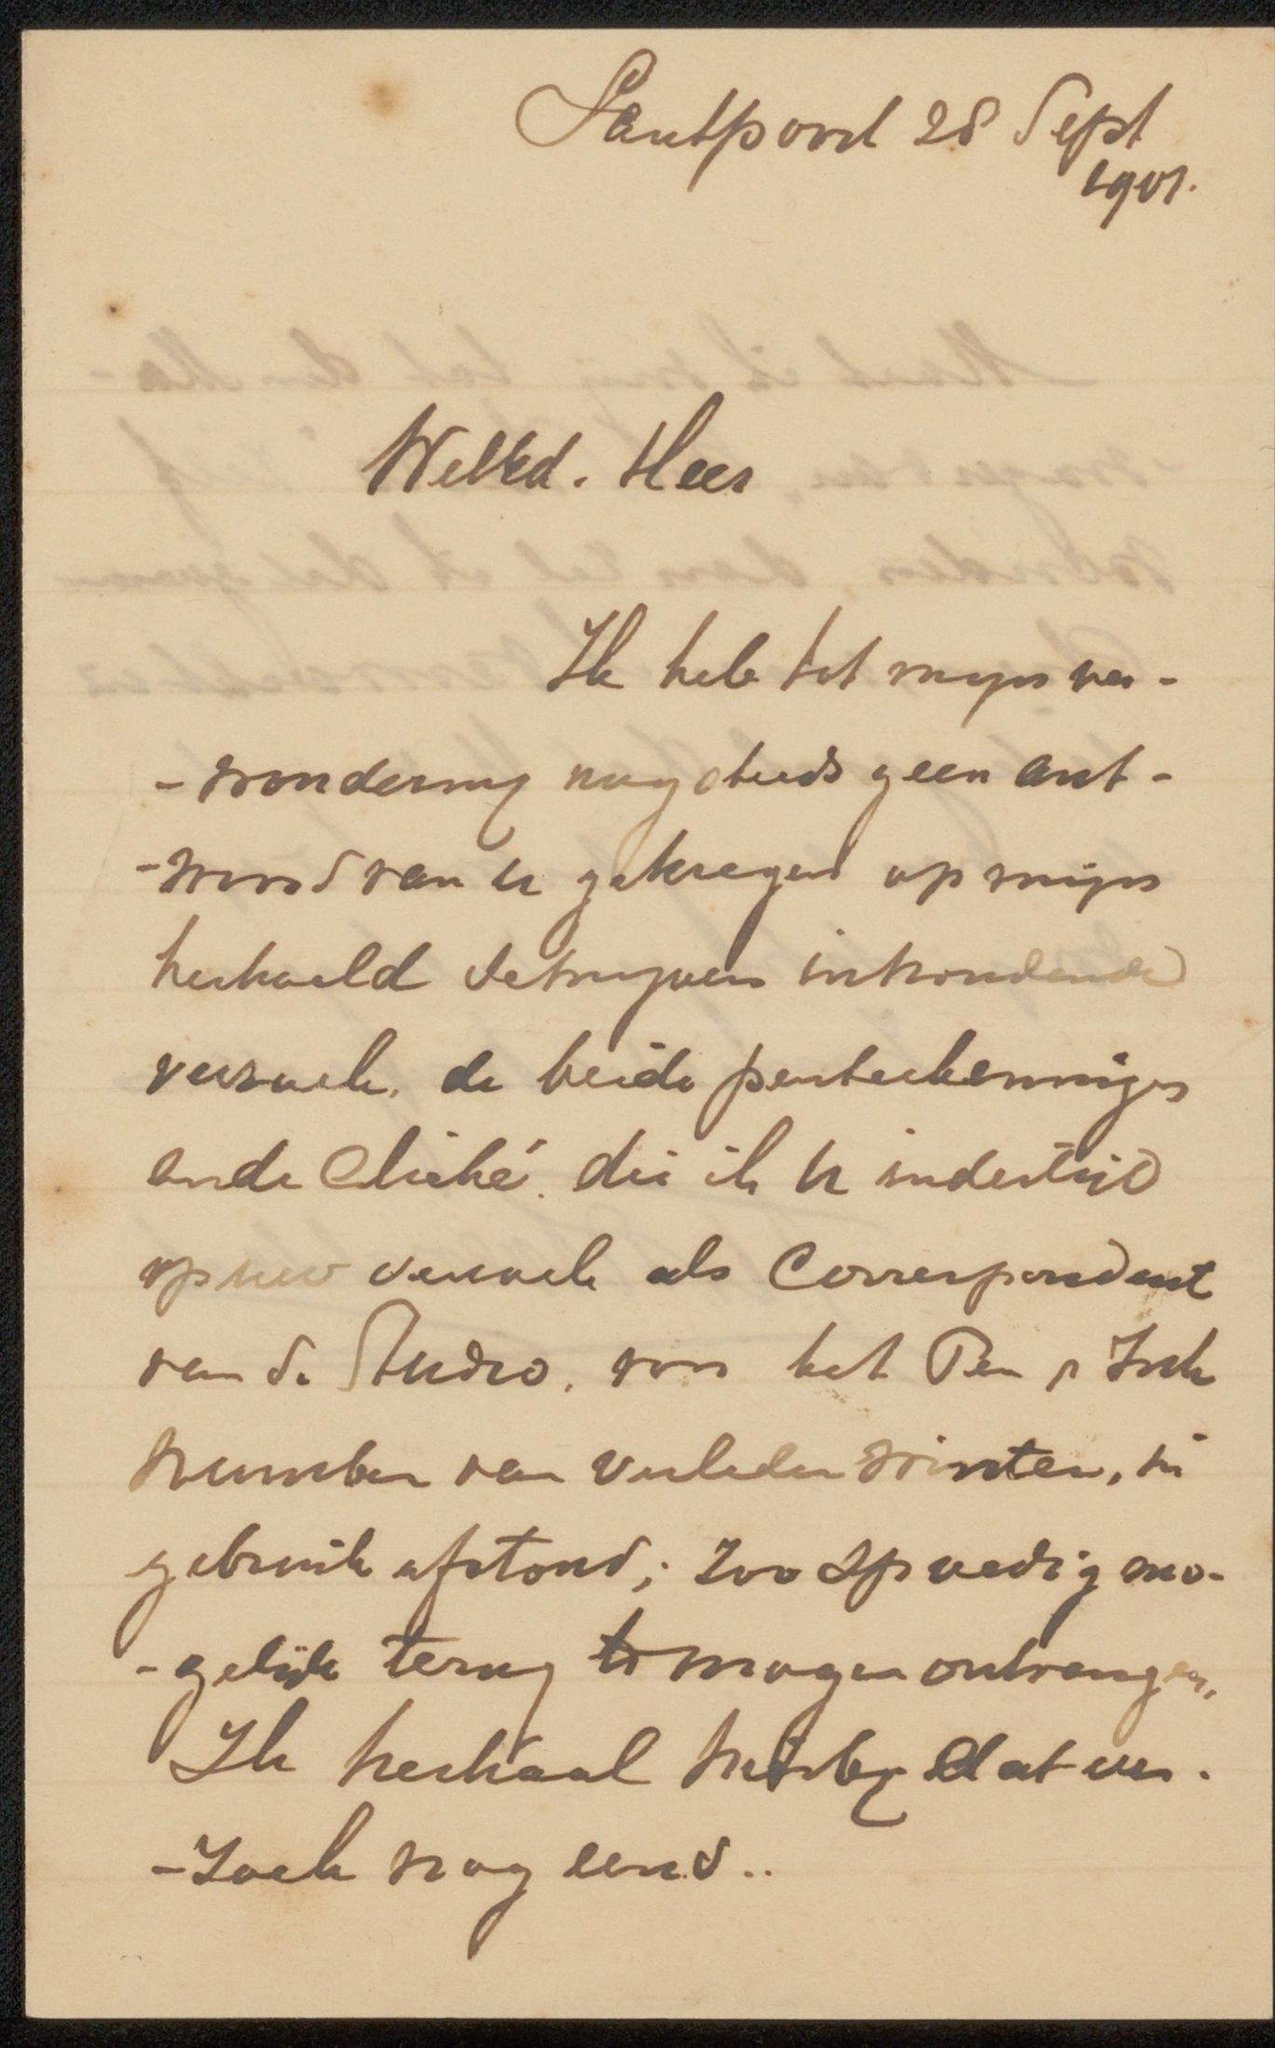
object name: letter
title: Brief aan Philip Zilcken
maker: willem wenckebach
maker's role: designer, draughtsman, painter, print maker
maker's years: 1860-1937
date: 1901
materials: ink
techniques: pen, writing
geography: santpoort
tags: philip zilcken, drawing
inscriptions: collector's mark: ‘RPK’